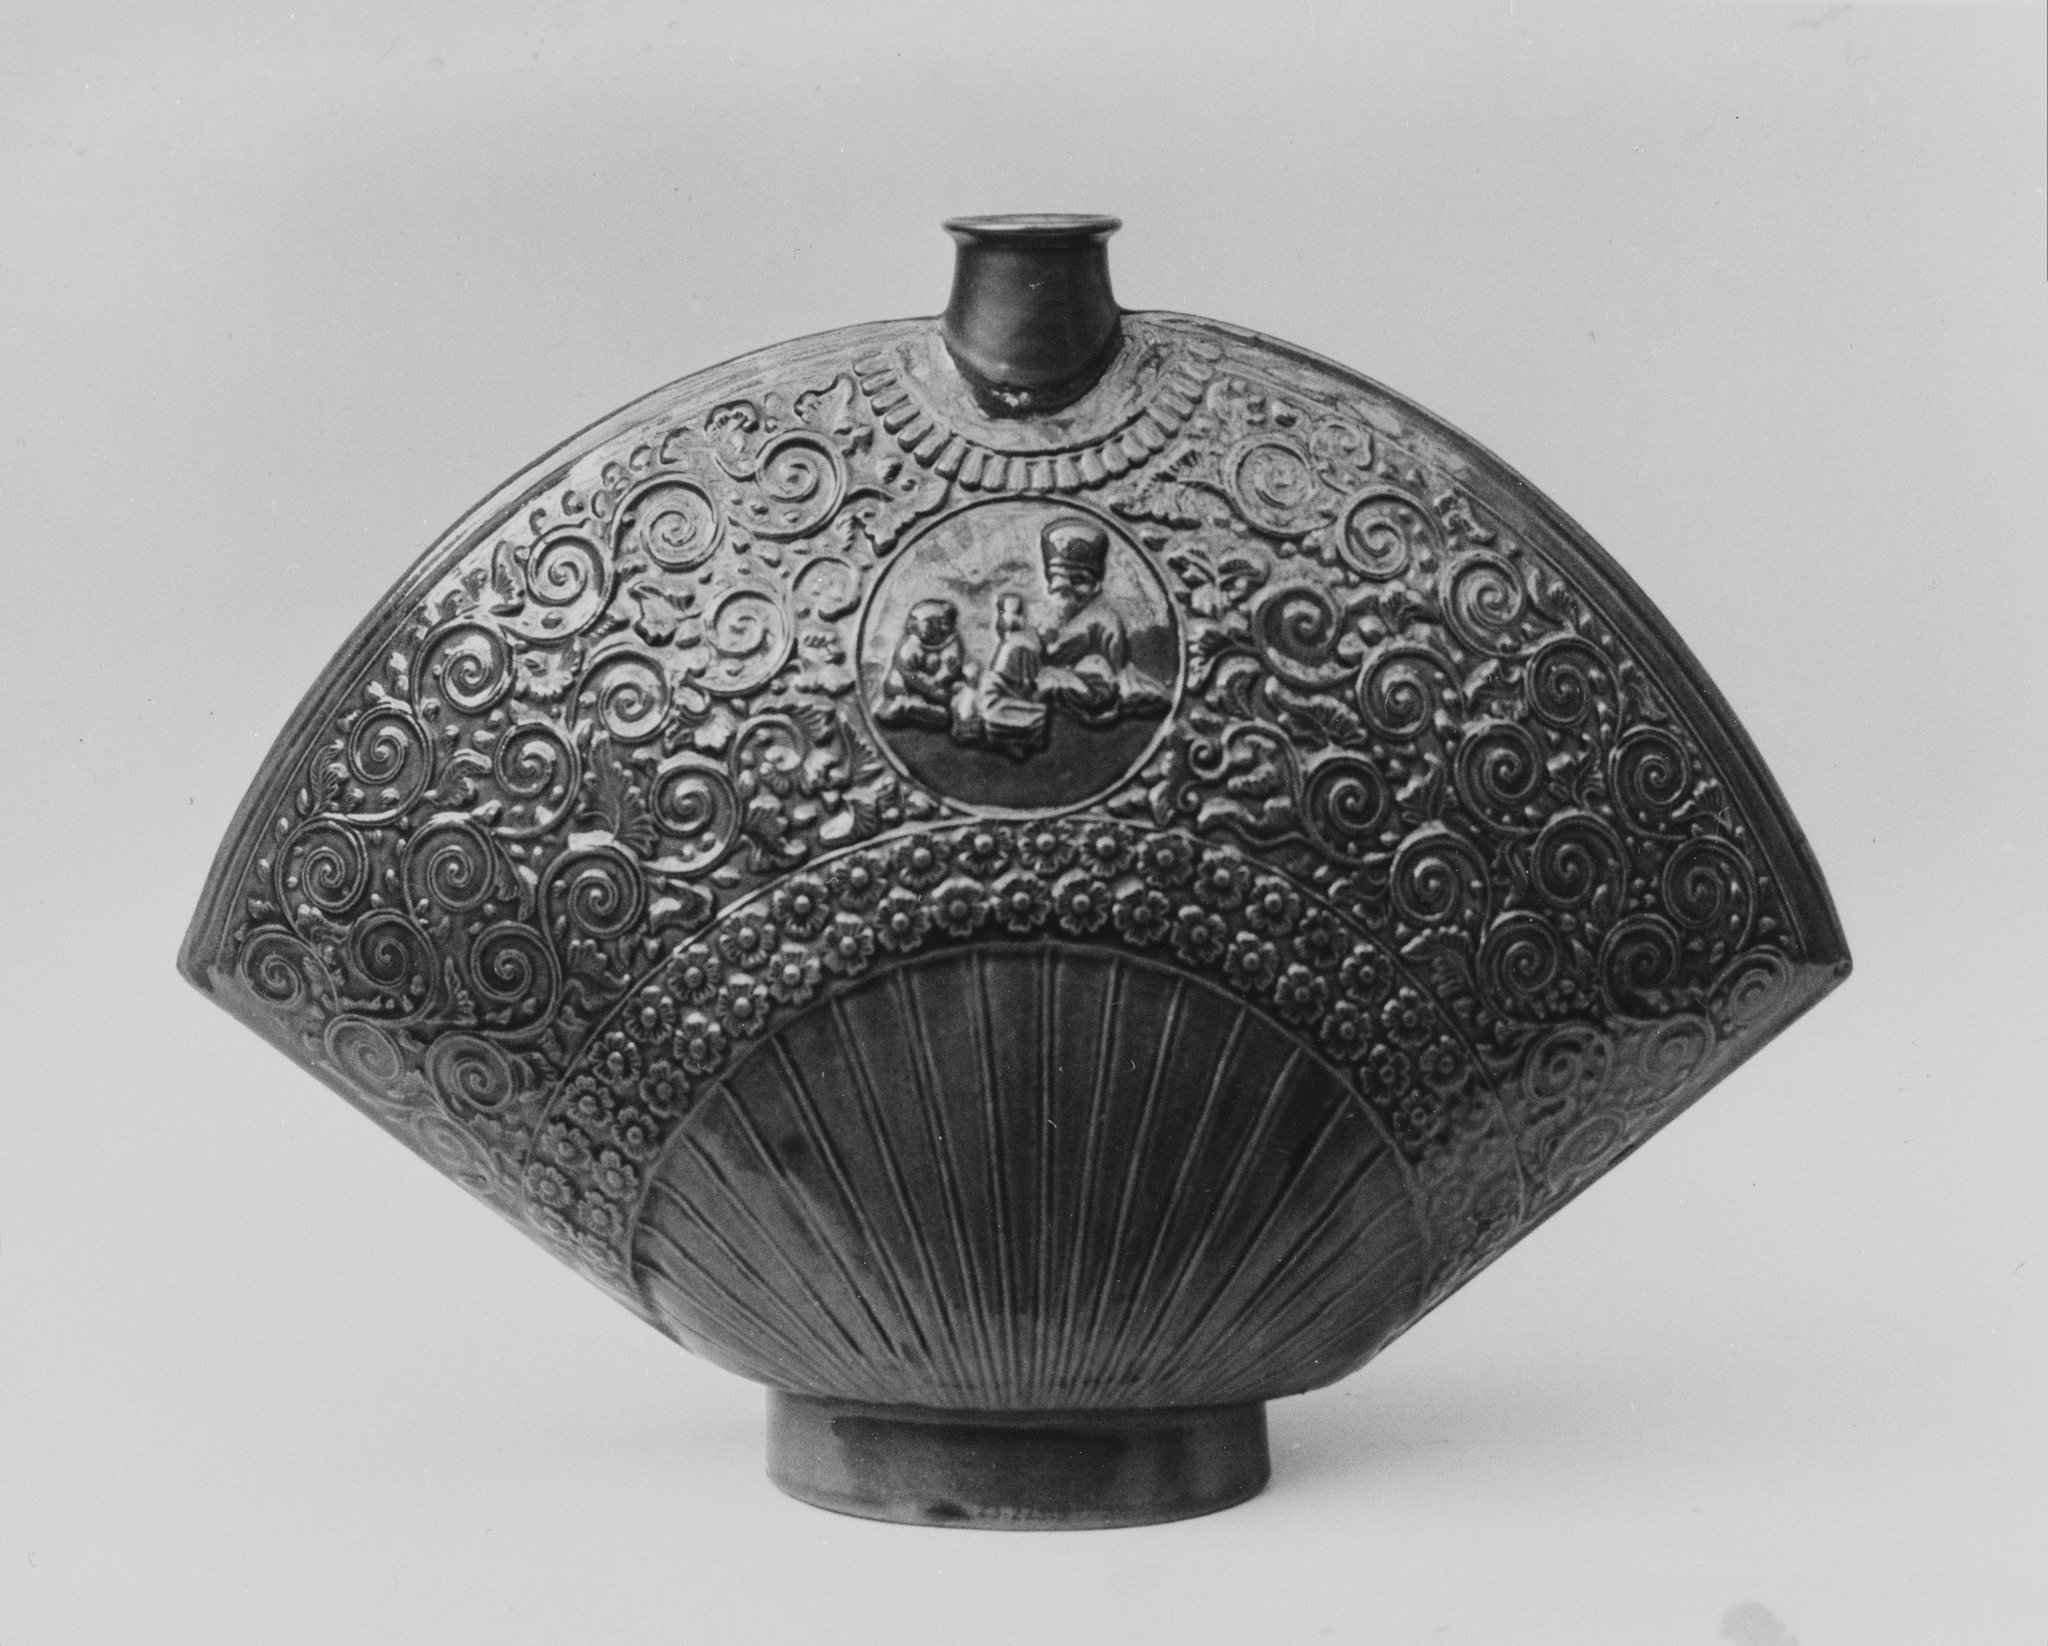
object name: bottle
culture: japanese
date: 1840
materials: glaze, porcelain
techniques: relief